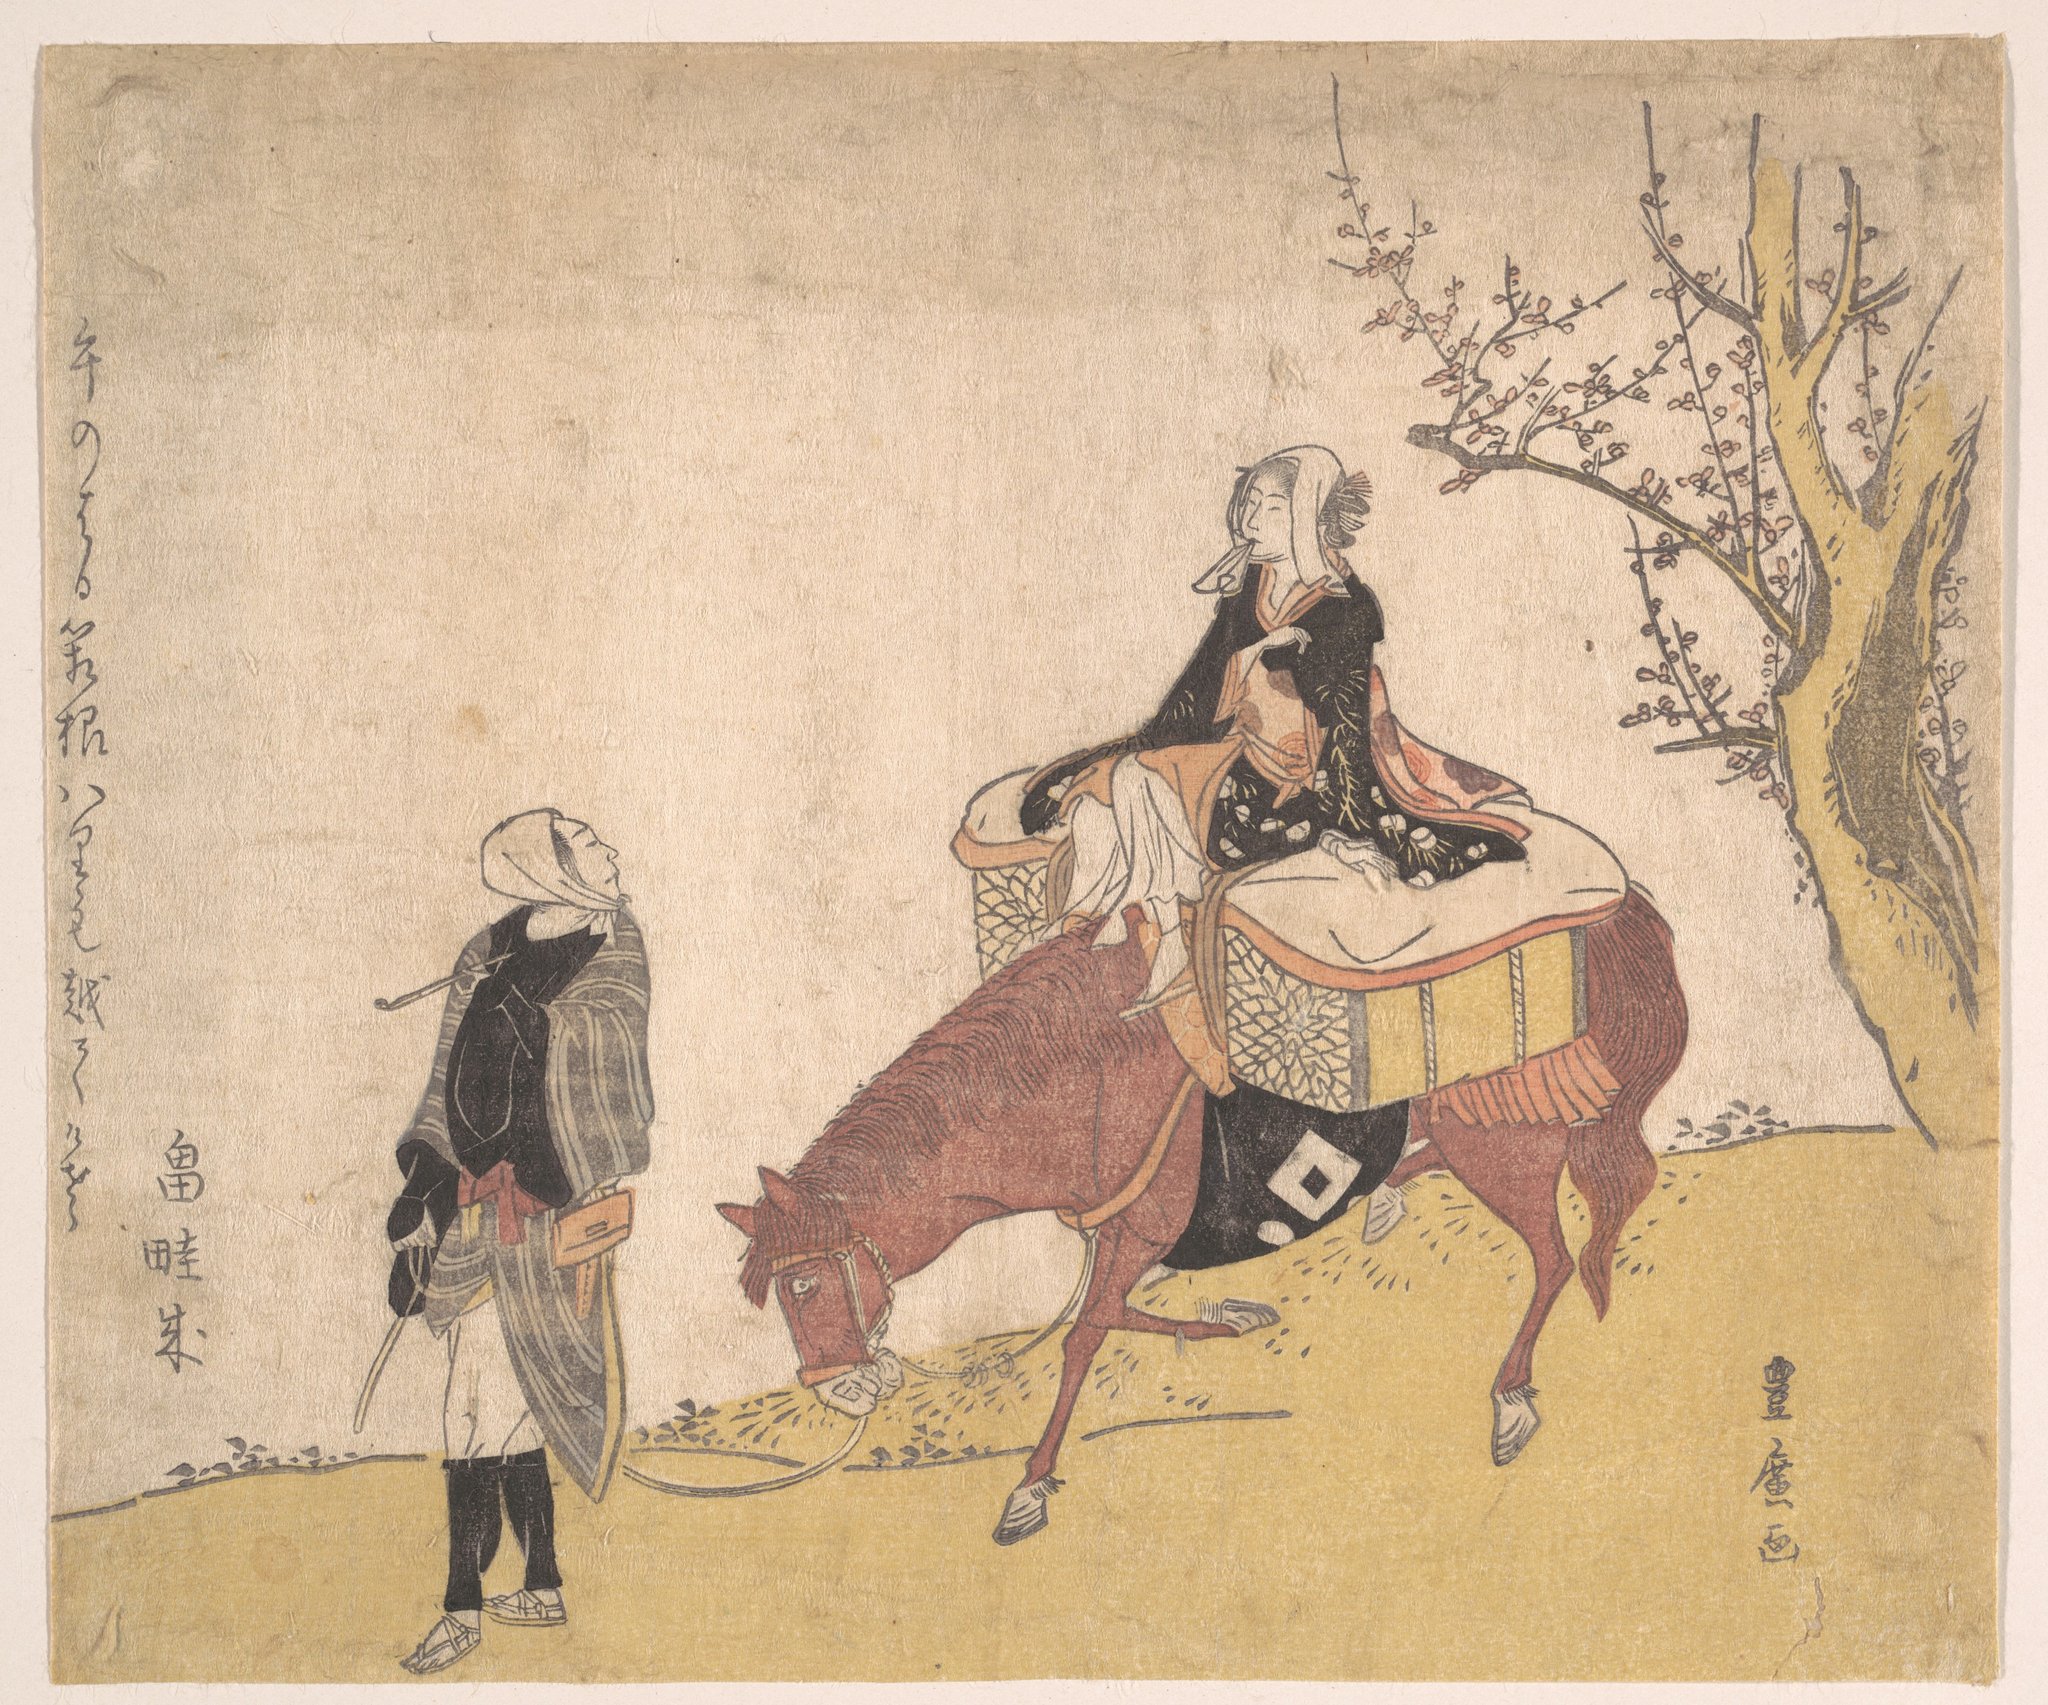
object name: print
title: Version of Legend of Michizane: Woman Riding Ox Which a Man is Leading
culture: japanese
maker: utagawa toyohiro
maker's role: artist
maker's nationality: japanese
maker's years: 1763-1828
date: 1763-1828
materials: ink, paper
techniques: surimono, woodblock print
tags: men,horses,trees